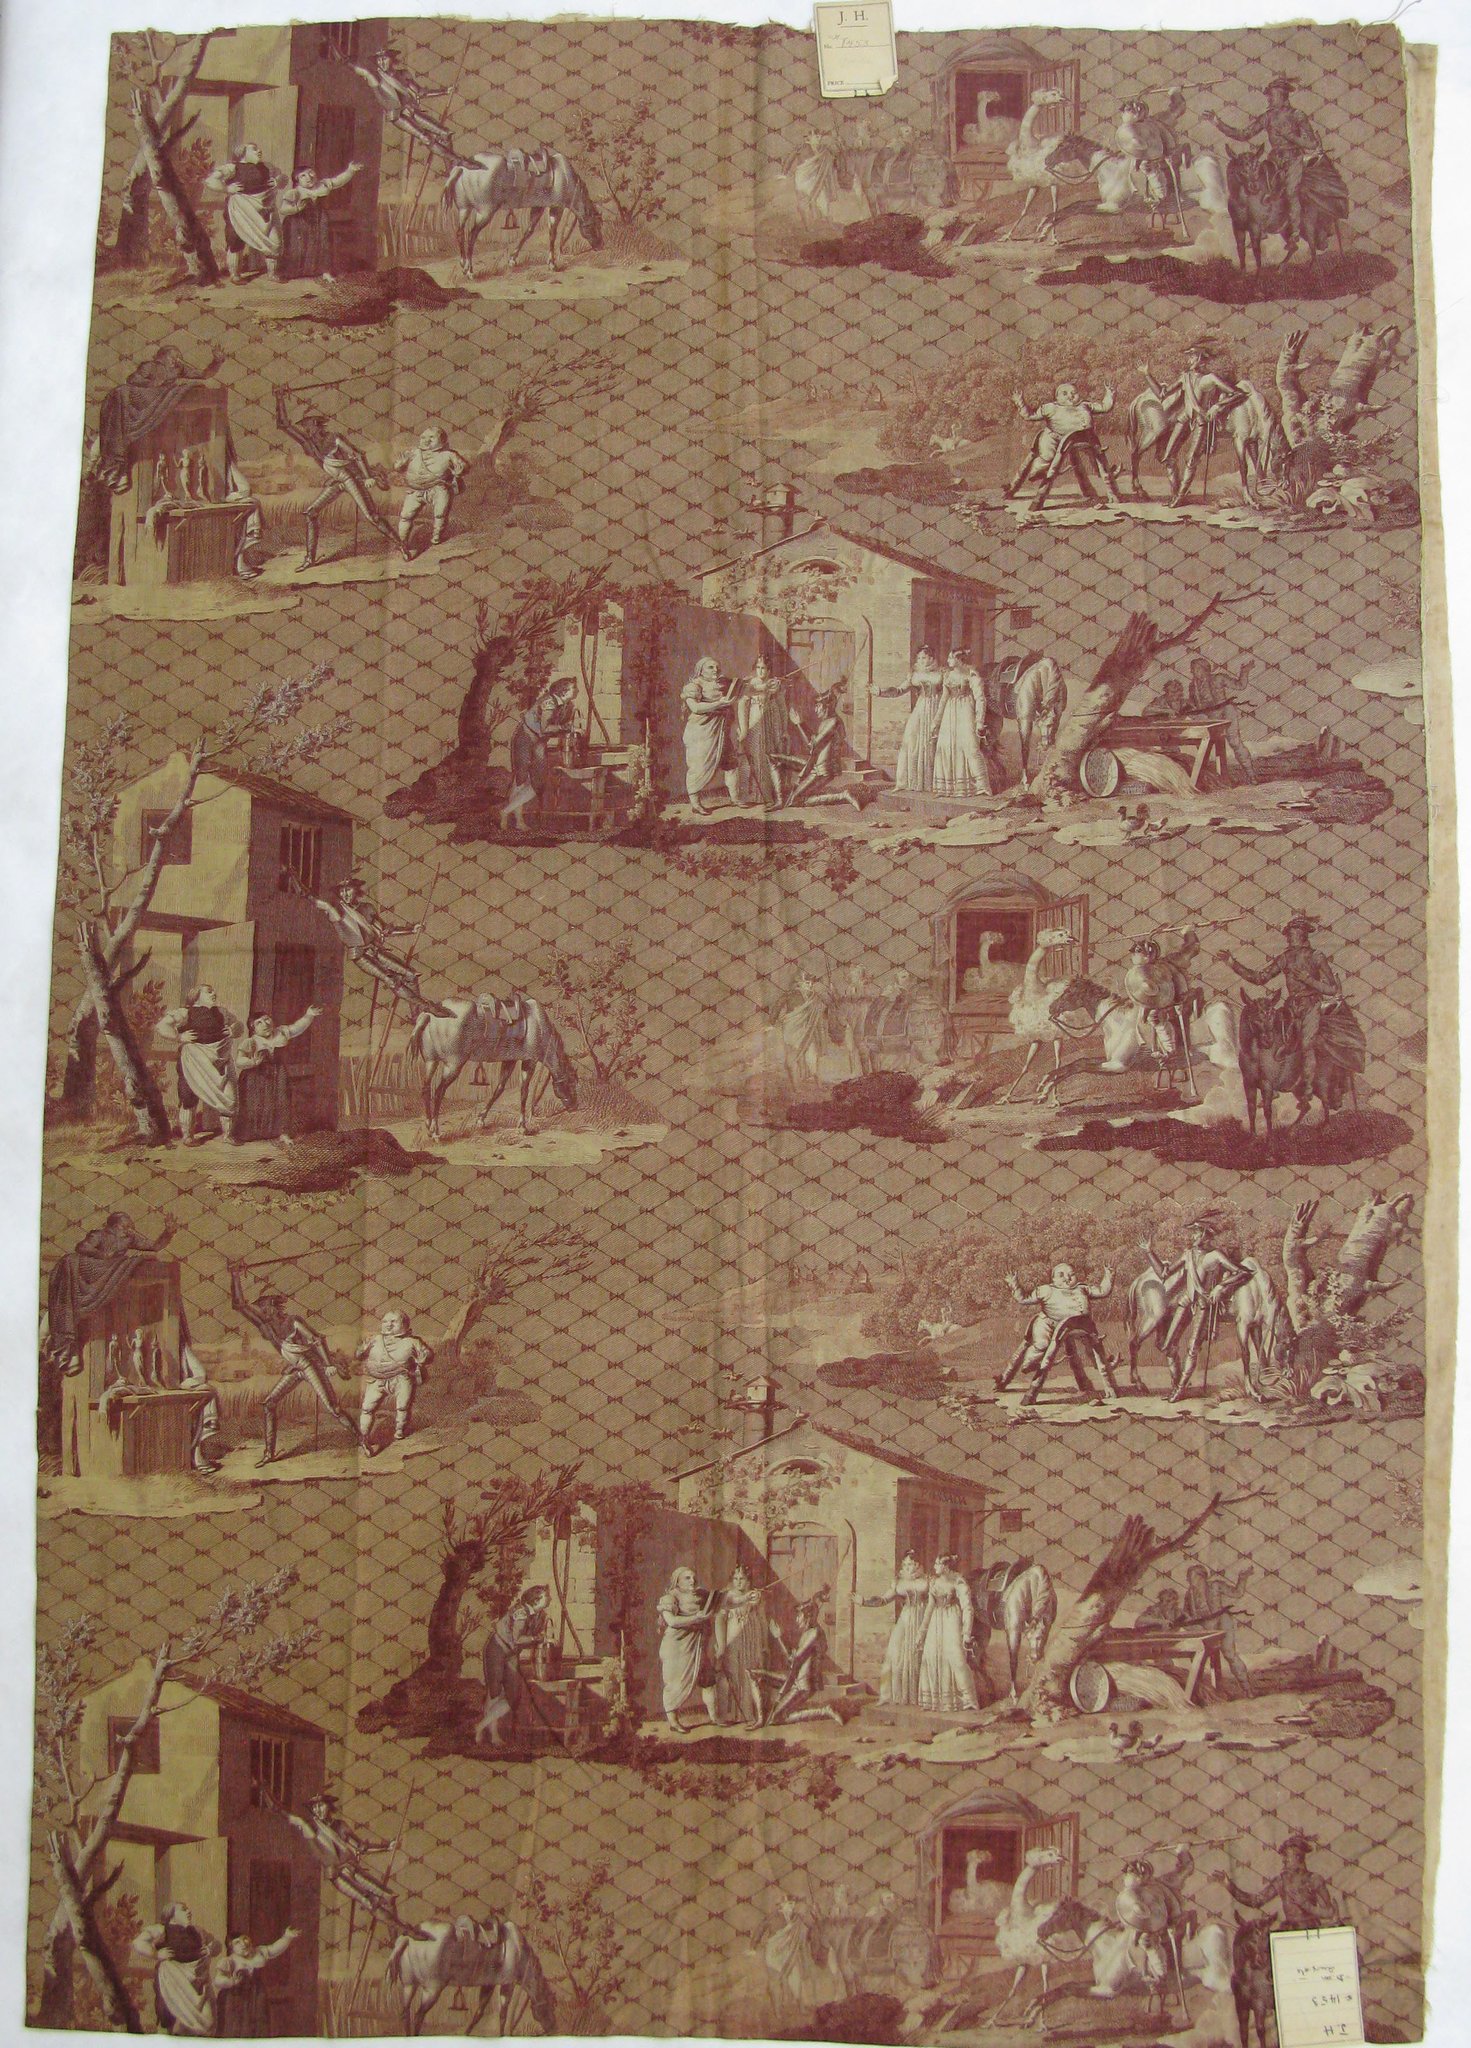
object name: length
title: Scenes from "El ingenioso hidalgo Don Quijote de la Mancha" by Miguel de Cervantes Saavedra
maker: françois joseph heim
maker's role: designer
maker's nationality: french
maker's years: 1787-1865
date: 1813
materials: cotton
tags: houses,men,women,horses,trees